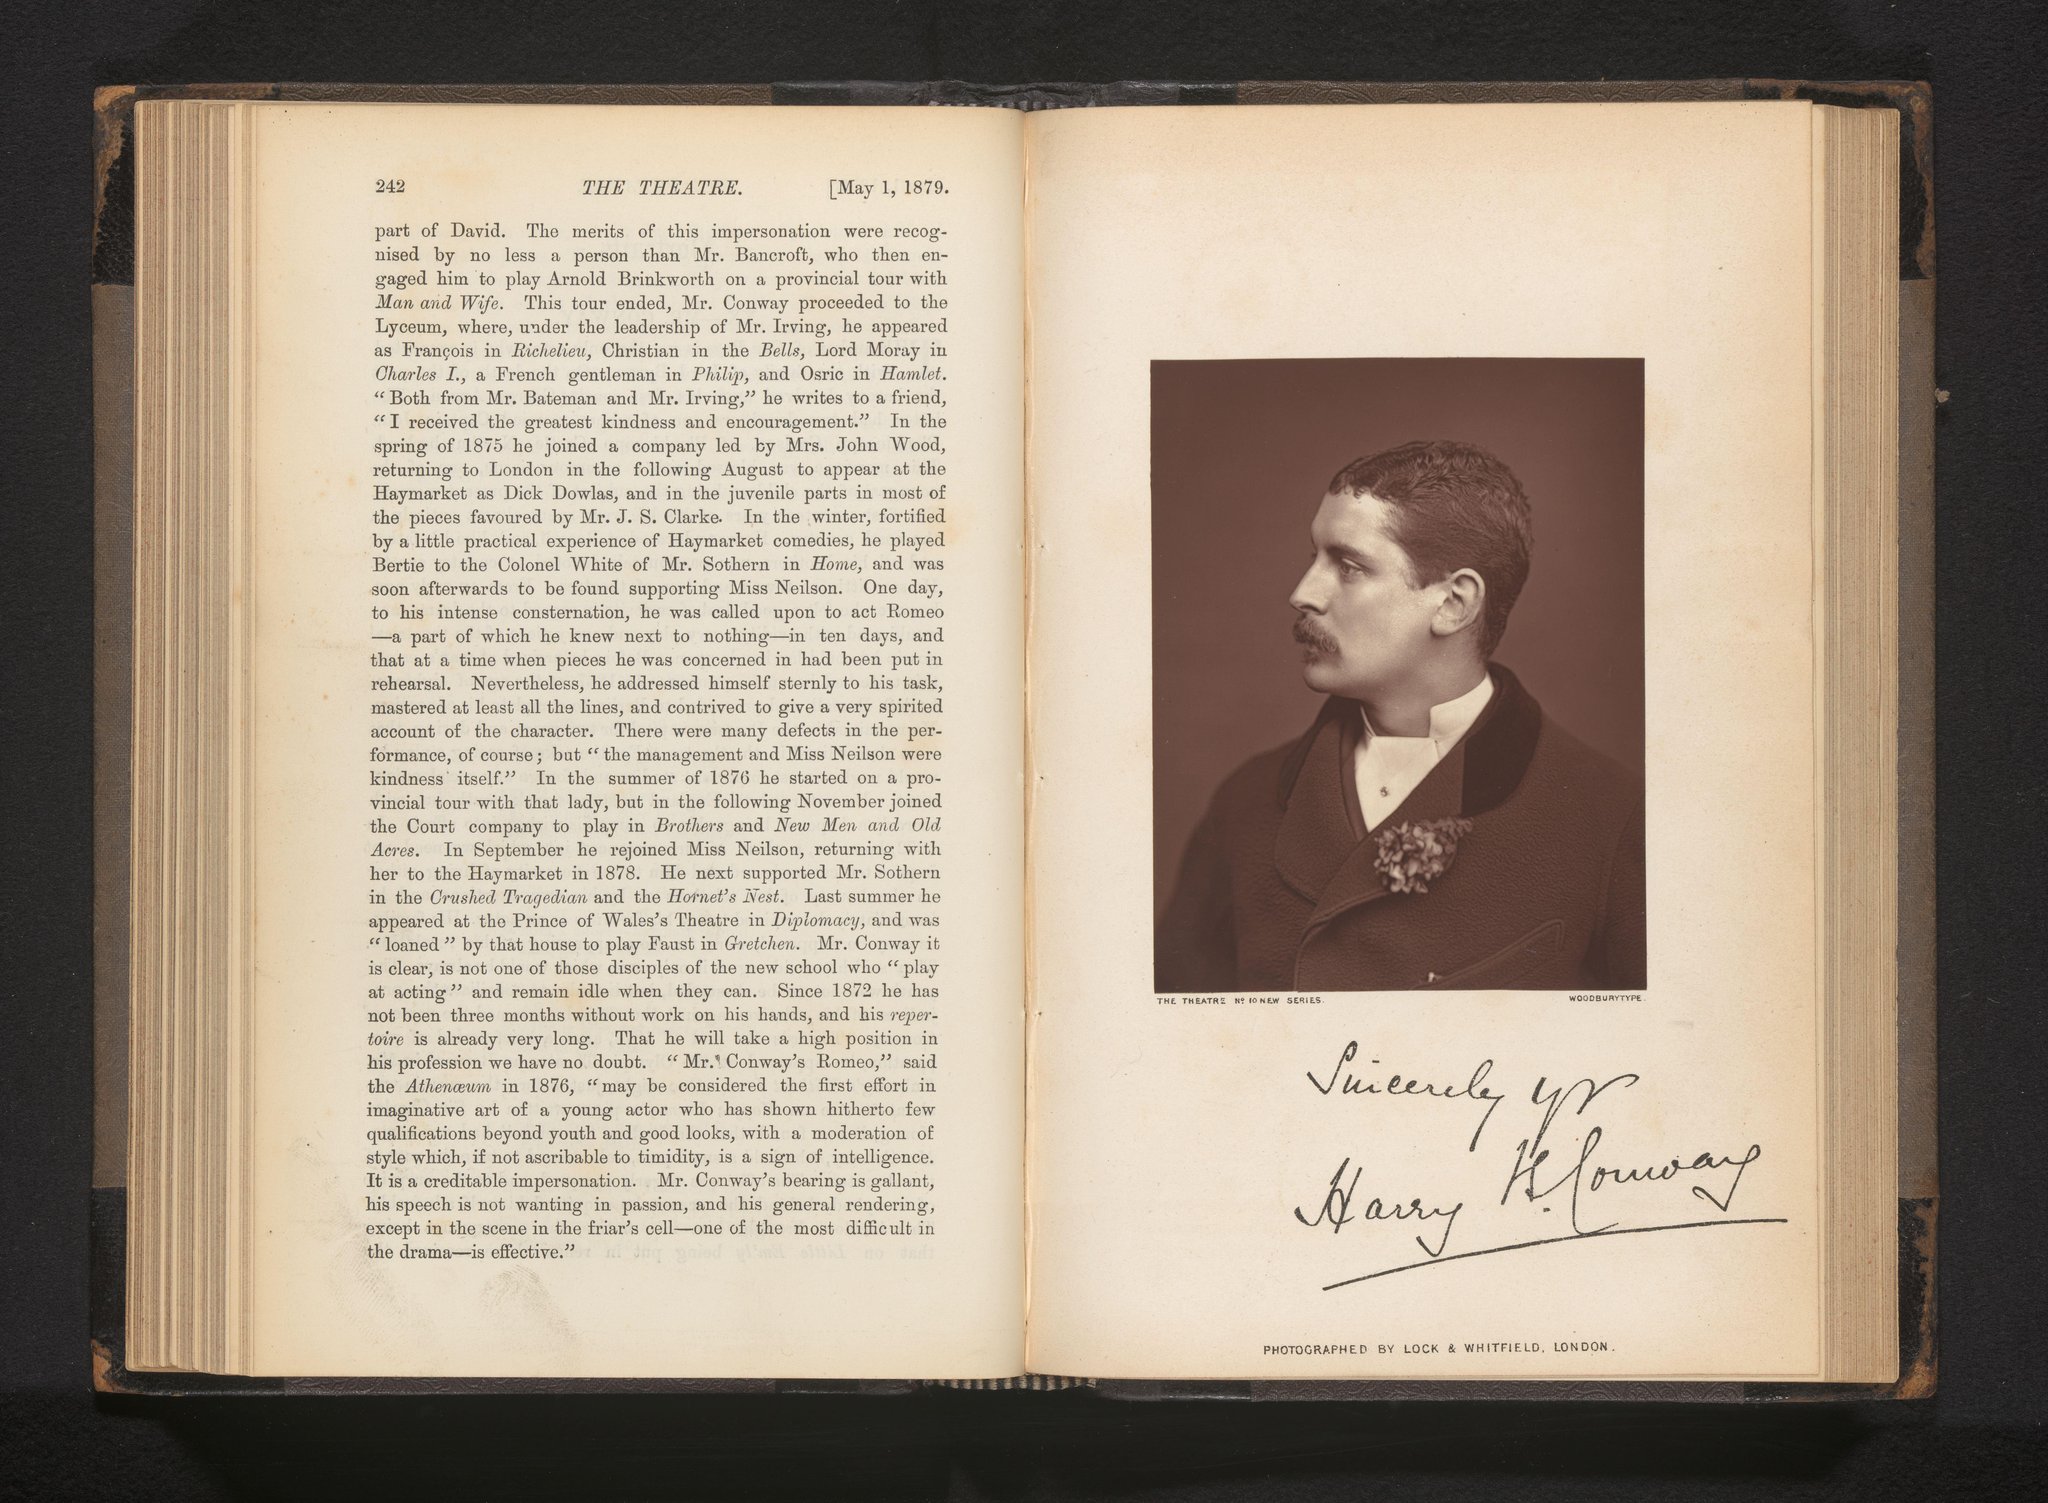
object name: page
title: Portret van Mr Conway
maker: Anonymous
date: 1874-1879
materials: paper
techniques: woodburytype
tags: adult man, historical persons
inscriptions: signature: ‘Sincerely/ Harry H. Conway’